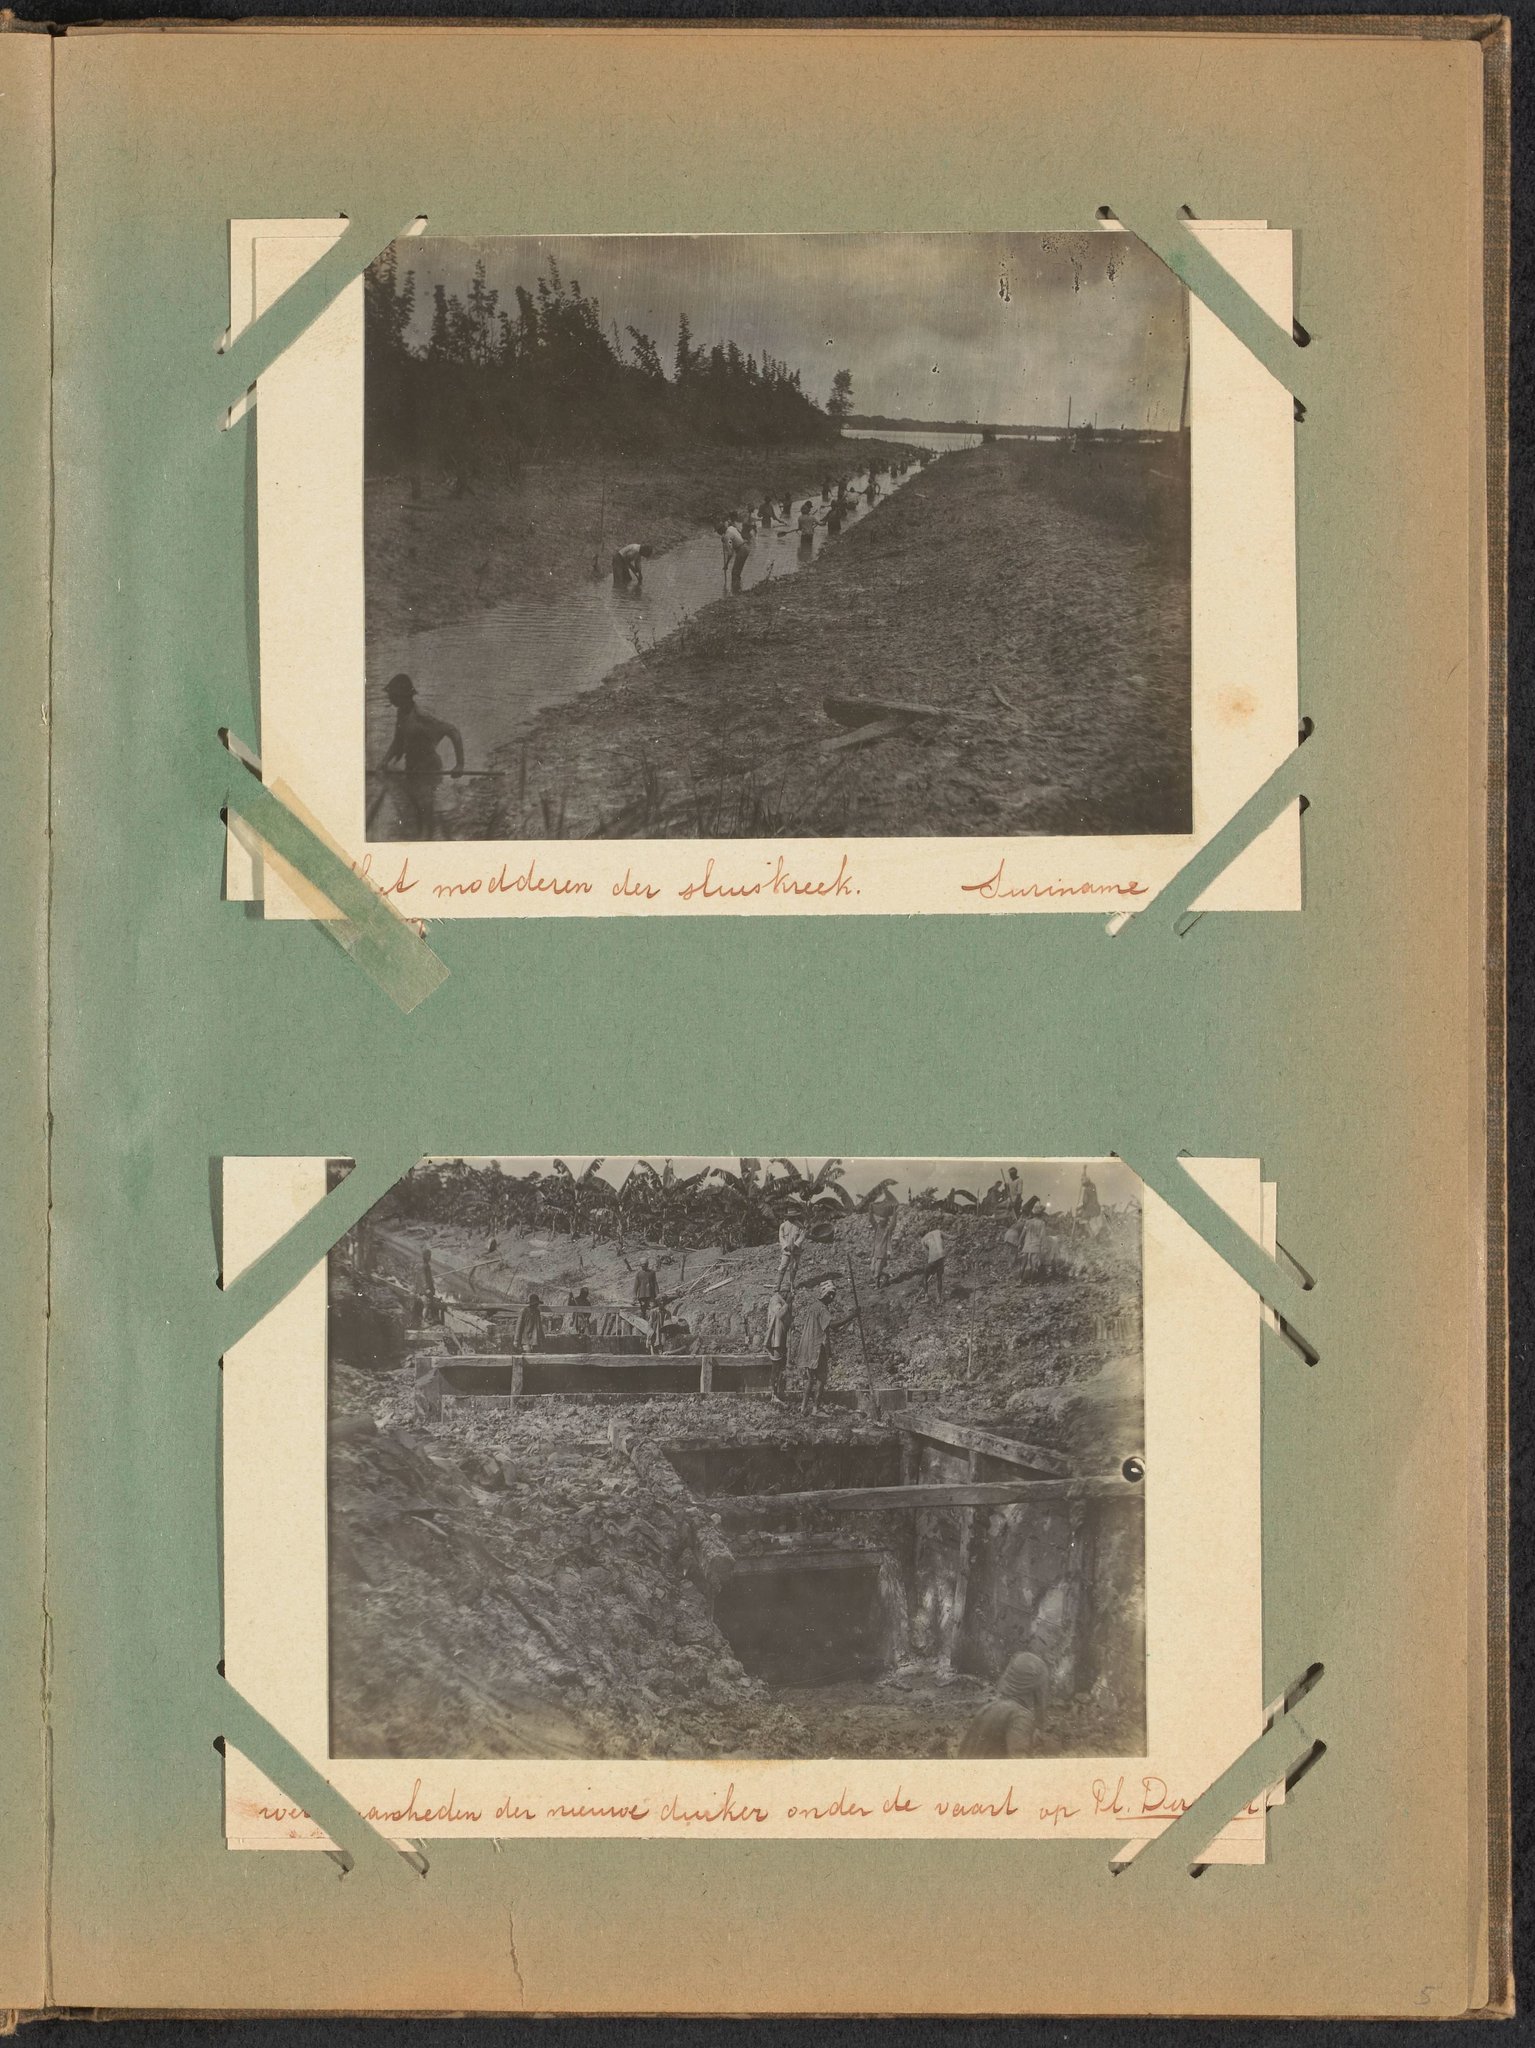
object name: photograph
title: Graafwerkzaamheden op Plantage Dordrecht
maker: Anonymous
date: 1912-1913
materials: paper, photographic support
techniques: gelatin silver print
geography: suriname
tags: plantation, suriname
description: Graafwerkzaamheden op Plantage Dordrecht in Suriname. Onderdeel van het fotoalbum uit ca. 1912-1913 met 92 foto's van de plantages Peperpot en Dordrecht in Suriname en Mount Pleasant op Curaçao.